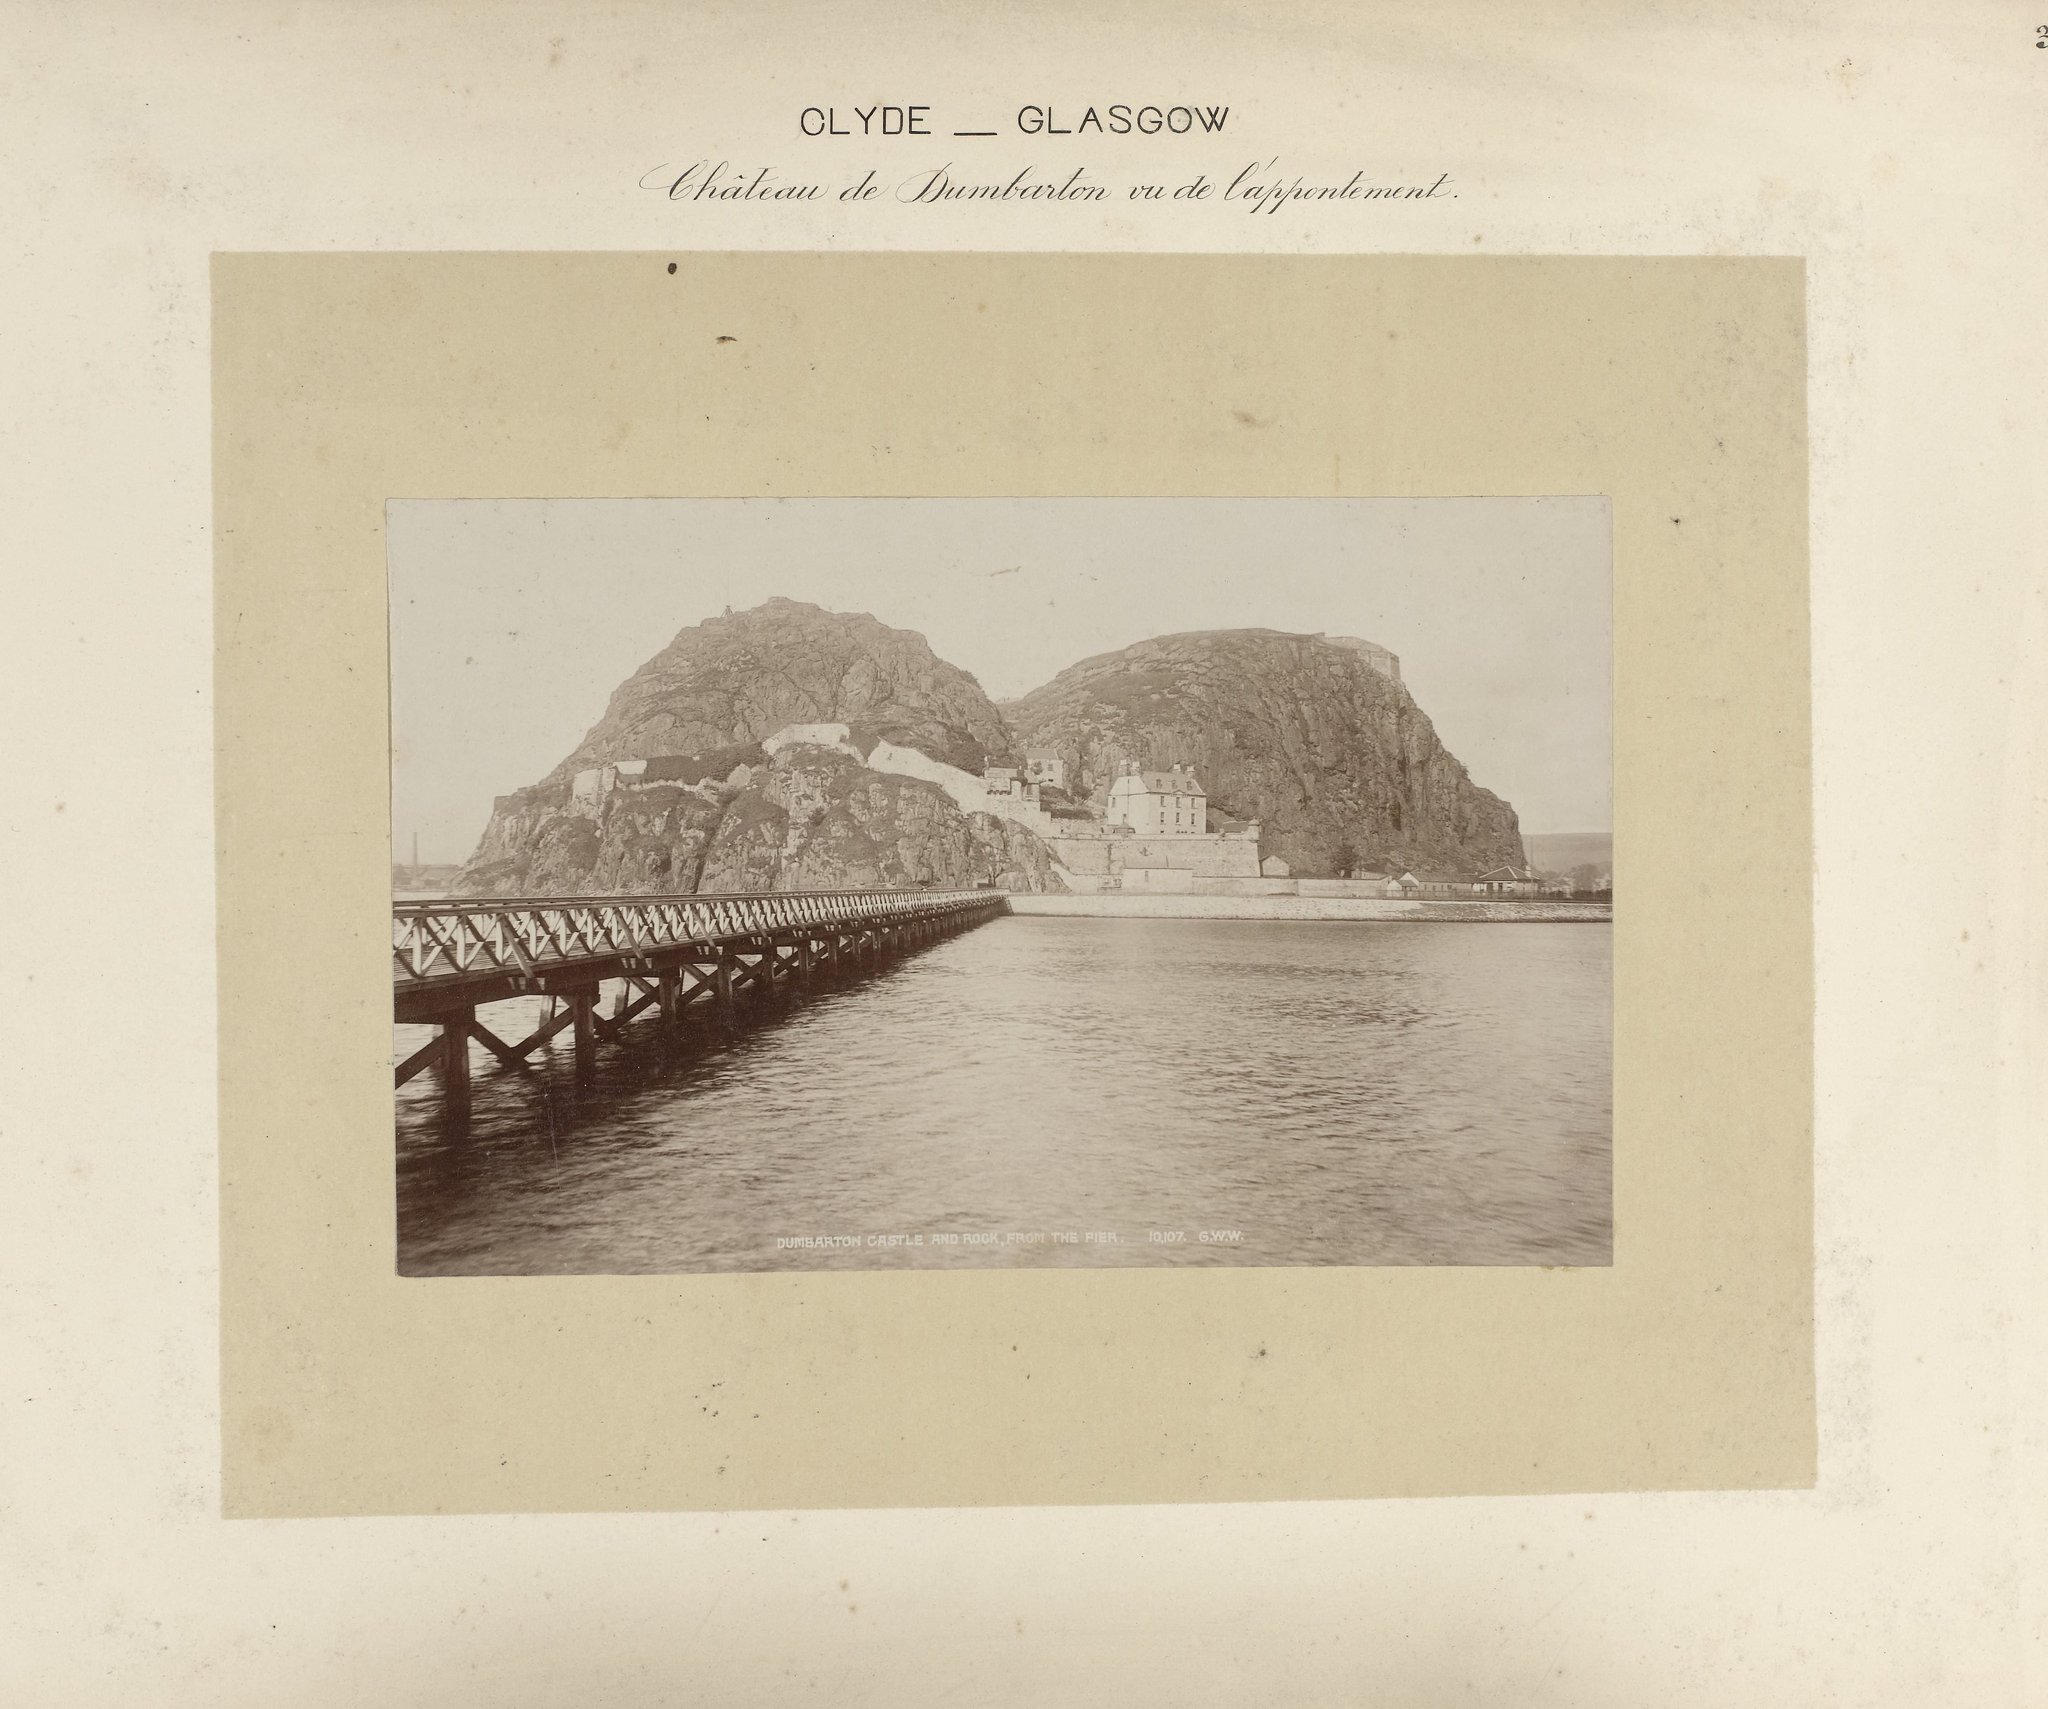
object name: photograph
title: Gezicht op Dumbarton Castle, Glasgow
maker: george washington wilson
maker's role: publisher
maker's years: 1823-1893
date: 1891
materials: cardboard, paper, photographic support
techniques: albumen print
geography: great britain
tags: glasgow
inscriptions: inscription: ‘CLYDE - GLASGOW / Château de Dumbarton vu de l'appontement’, inscription: ‘DUMBARTON CASTLE AND ROCK, FROM THE PIER. 10107. G.W.W.’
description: Foto uit een album met 35 topografische foto's van Britse kustplaatsen, waarop in pen militaire verdedigingswerken zijn aangegeven door een Franse militair.